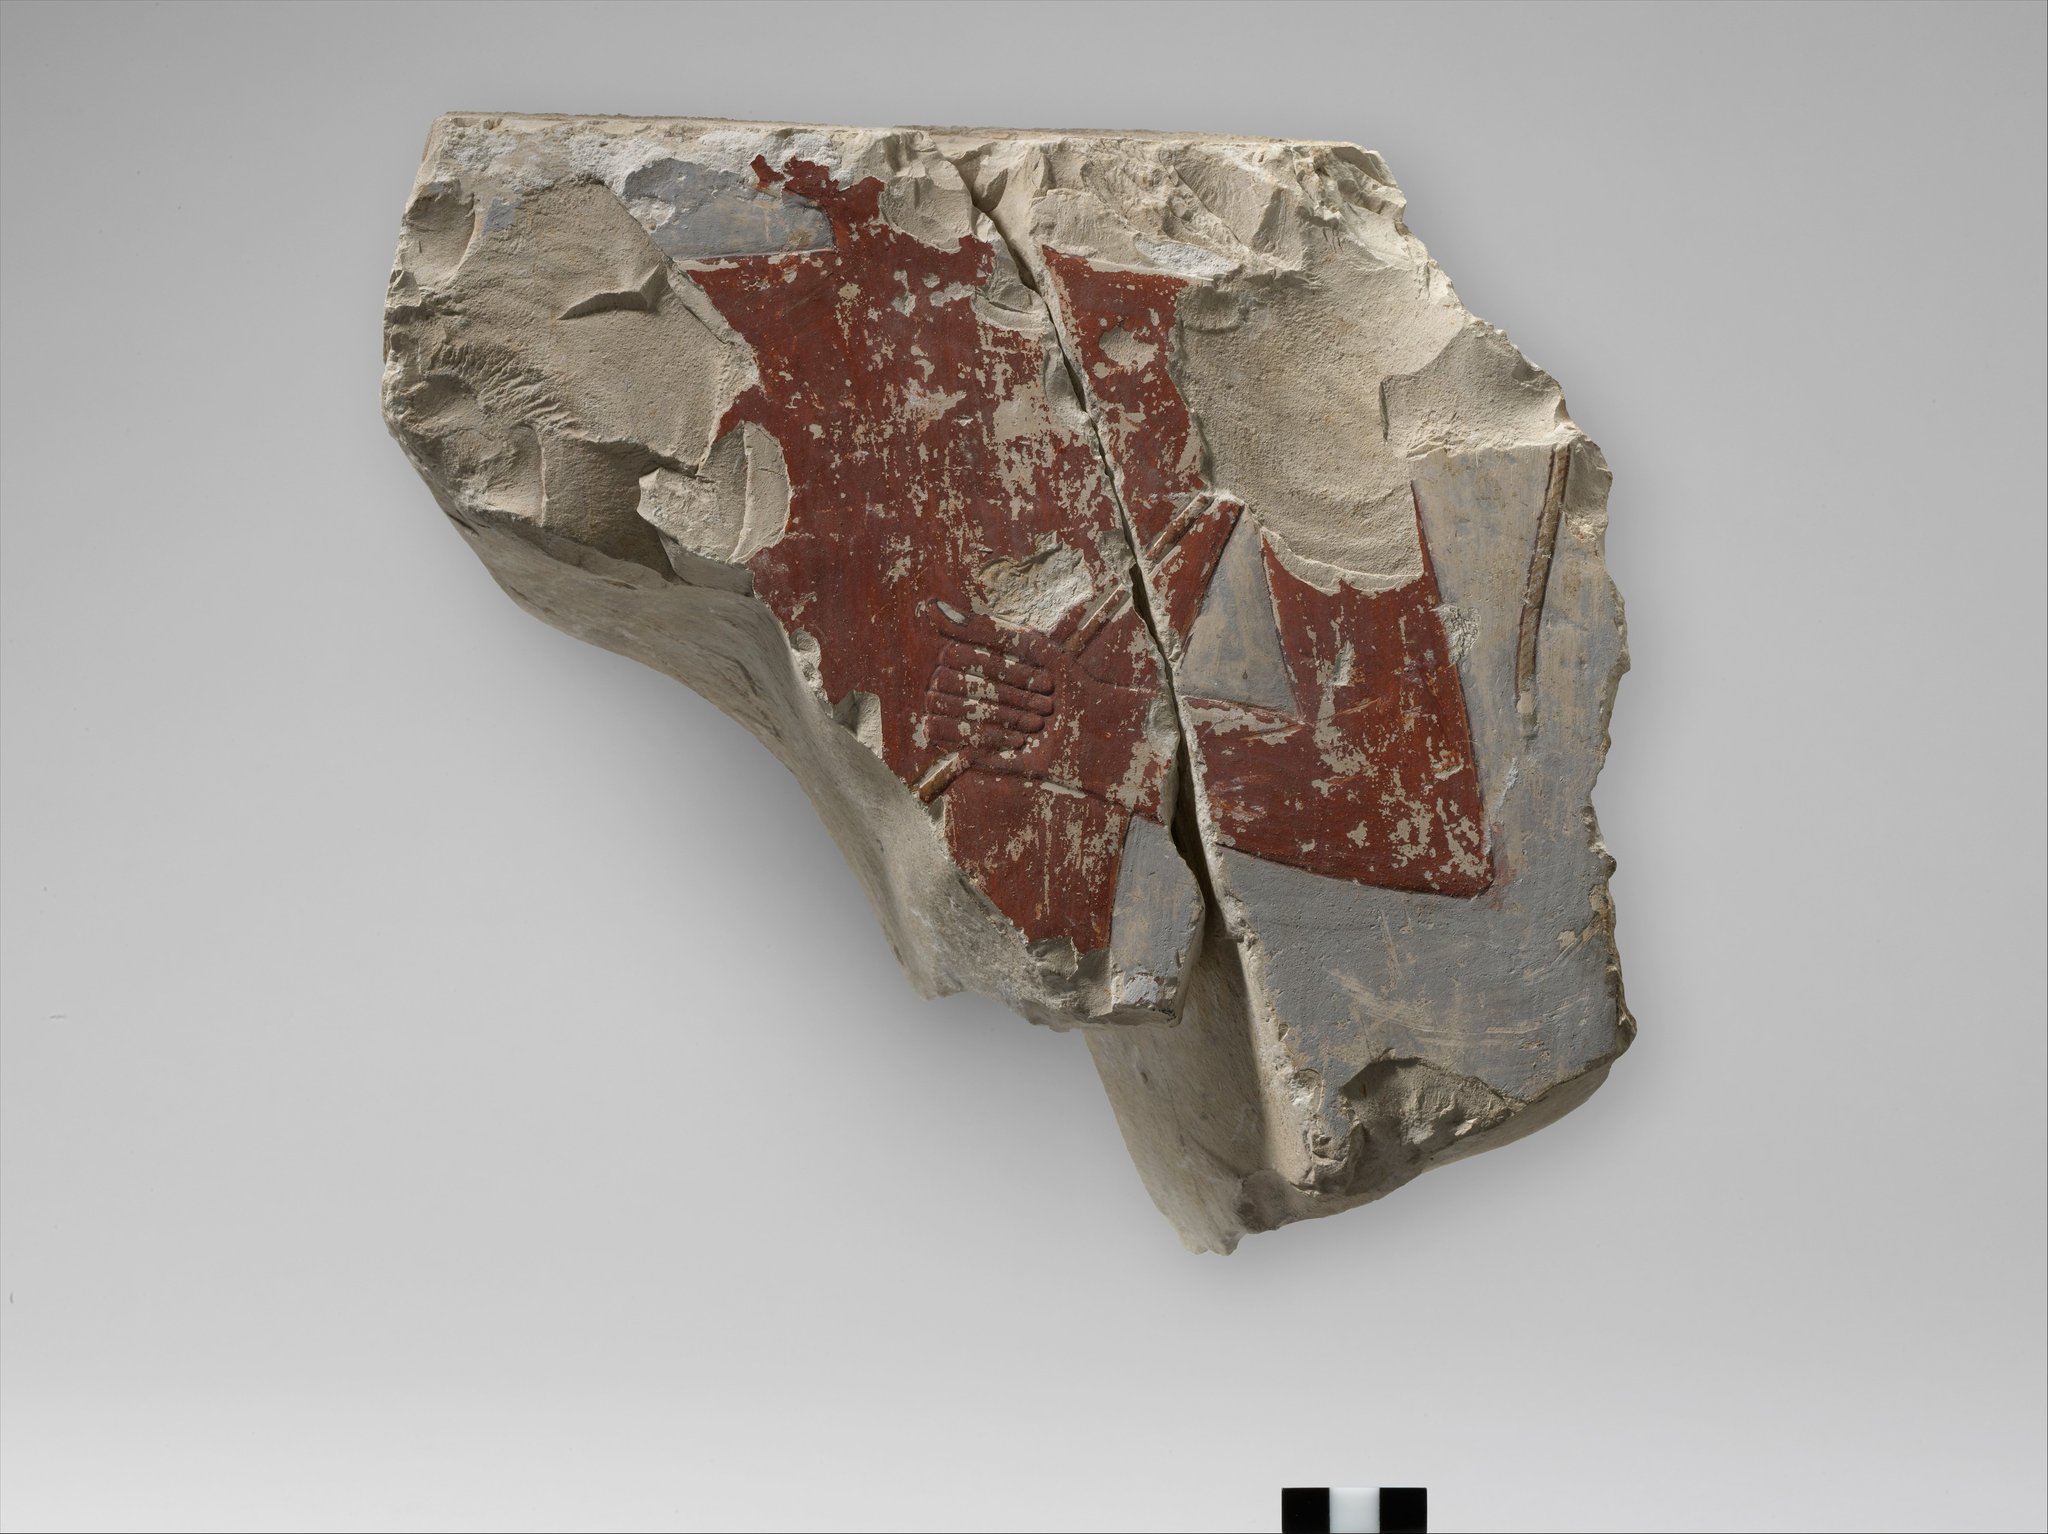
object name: relief fragment, tomb of meketre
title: Relief fragment from tomb of Meketre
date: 1981-1975 BCE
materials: limestone, paint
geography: egypt